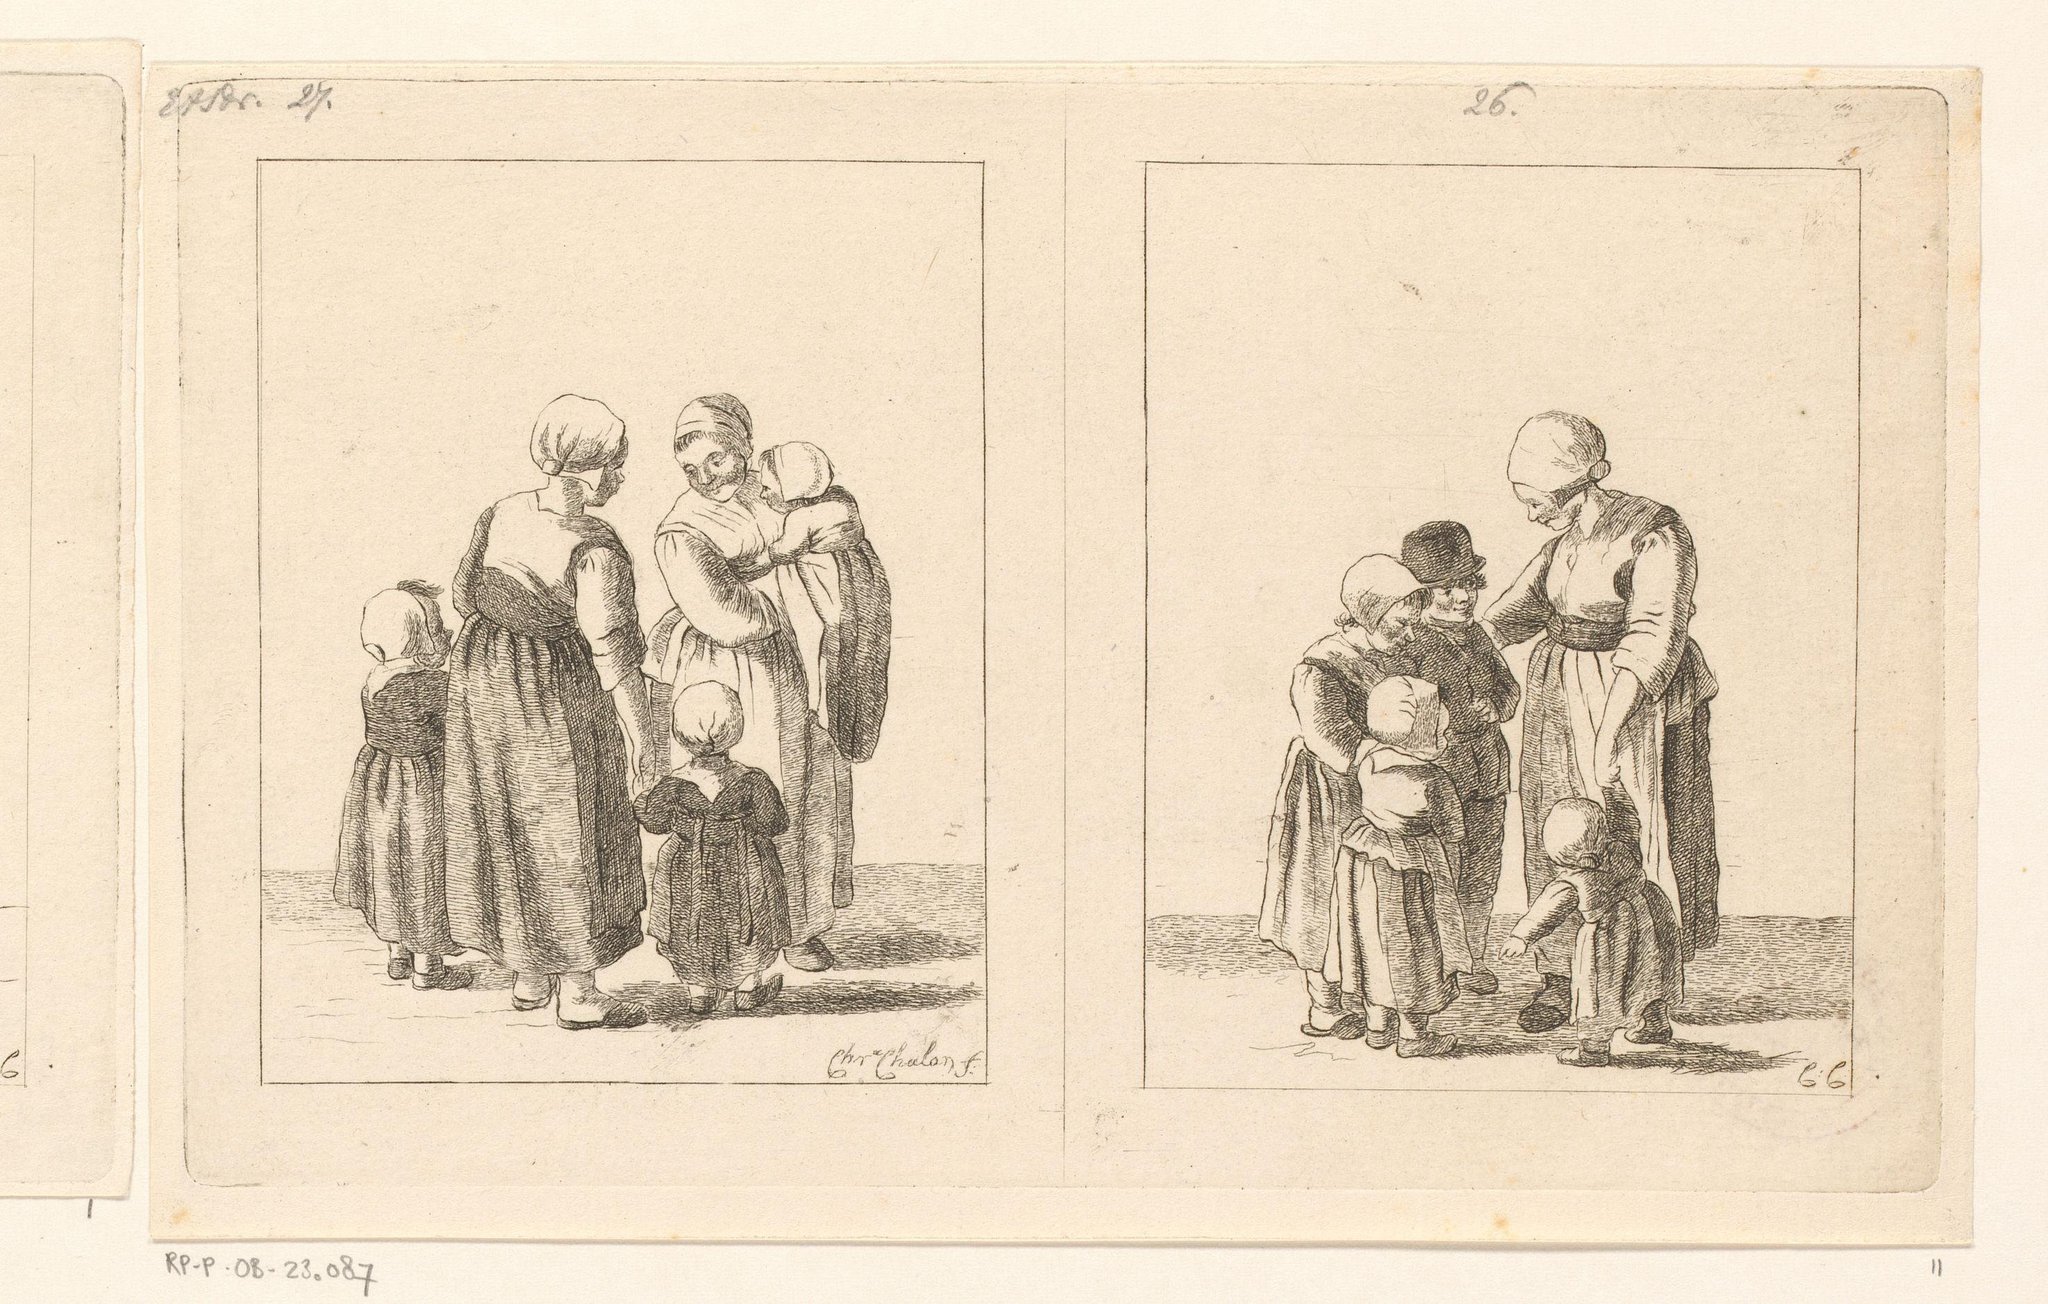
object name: print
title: Twee voorstellingen van kinderen en hun moeder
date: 1779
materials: paper, pencil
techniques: etching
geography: leiden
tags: mother and baby or young child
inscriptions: collector's mark: Lugt 240, number: ‘Etsdr. 27. 26.’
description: Twee voorstellingen van kinderen en hun moeder: links twee moeders in gesprek en rechts een moeder met vier kinderen.